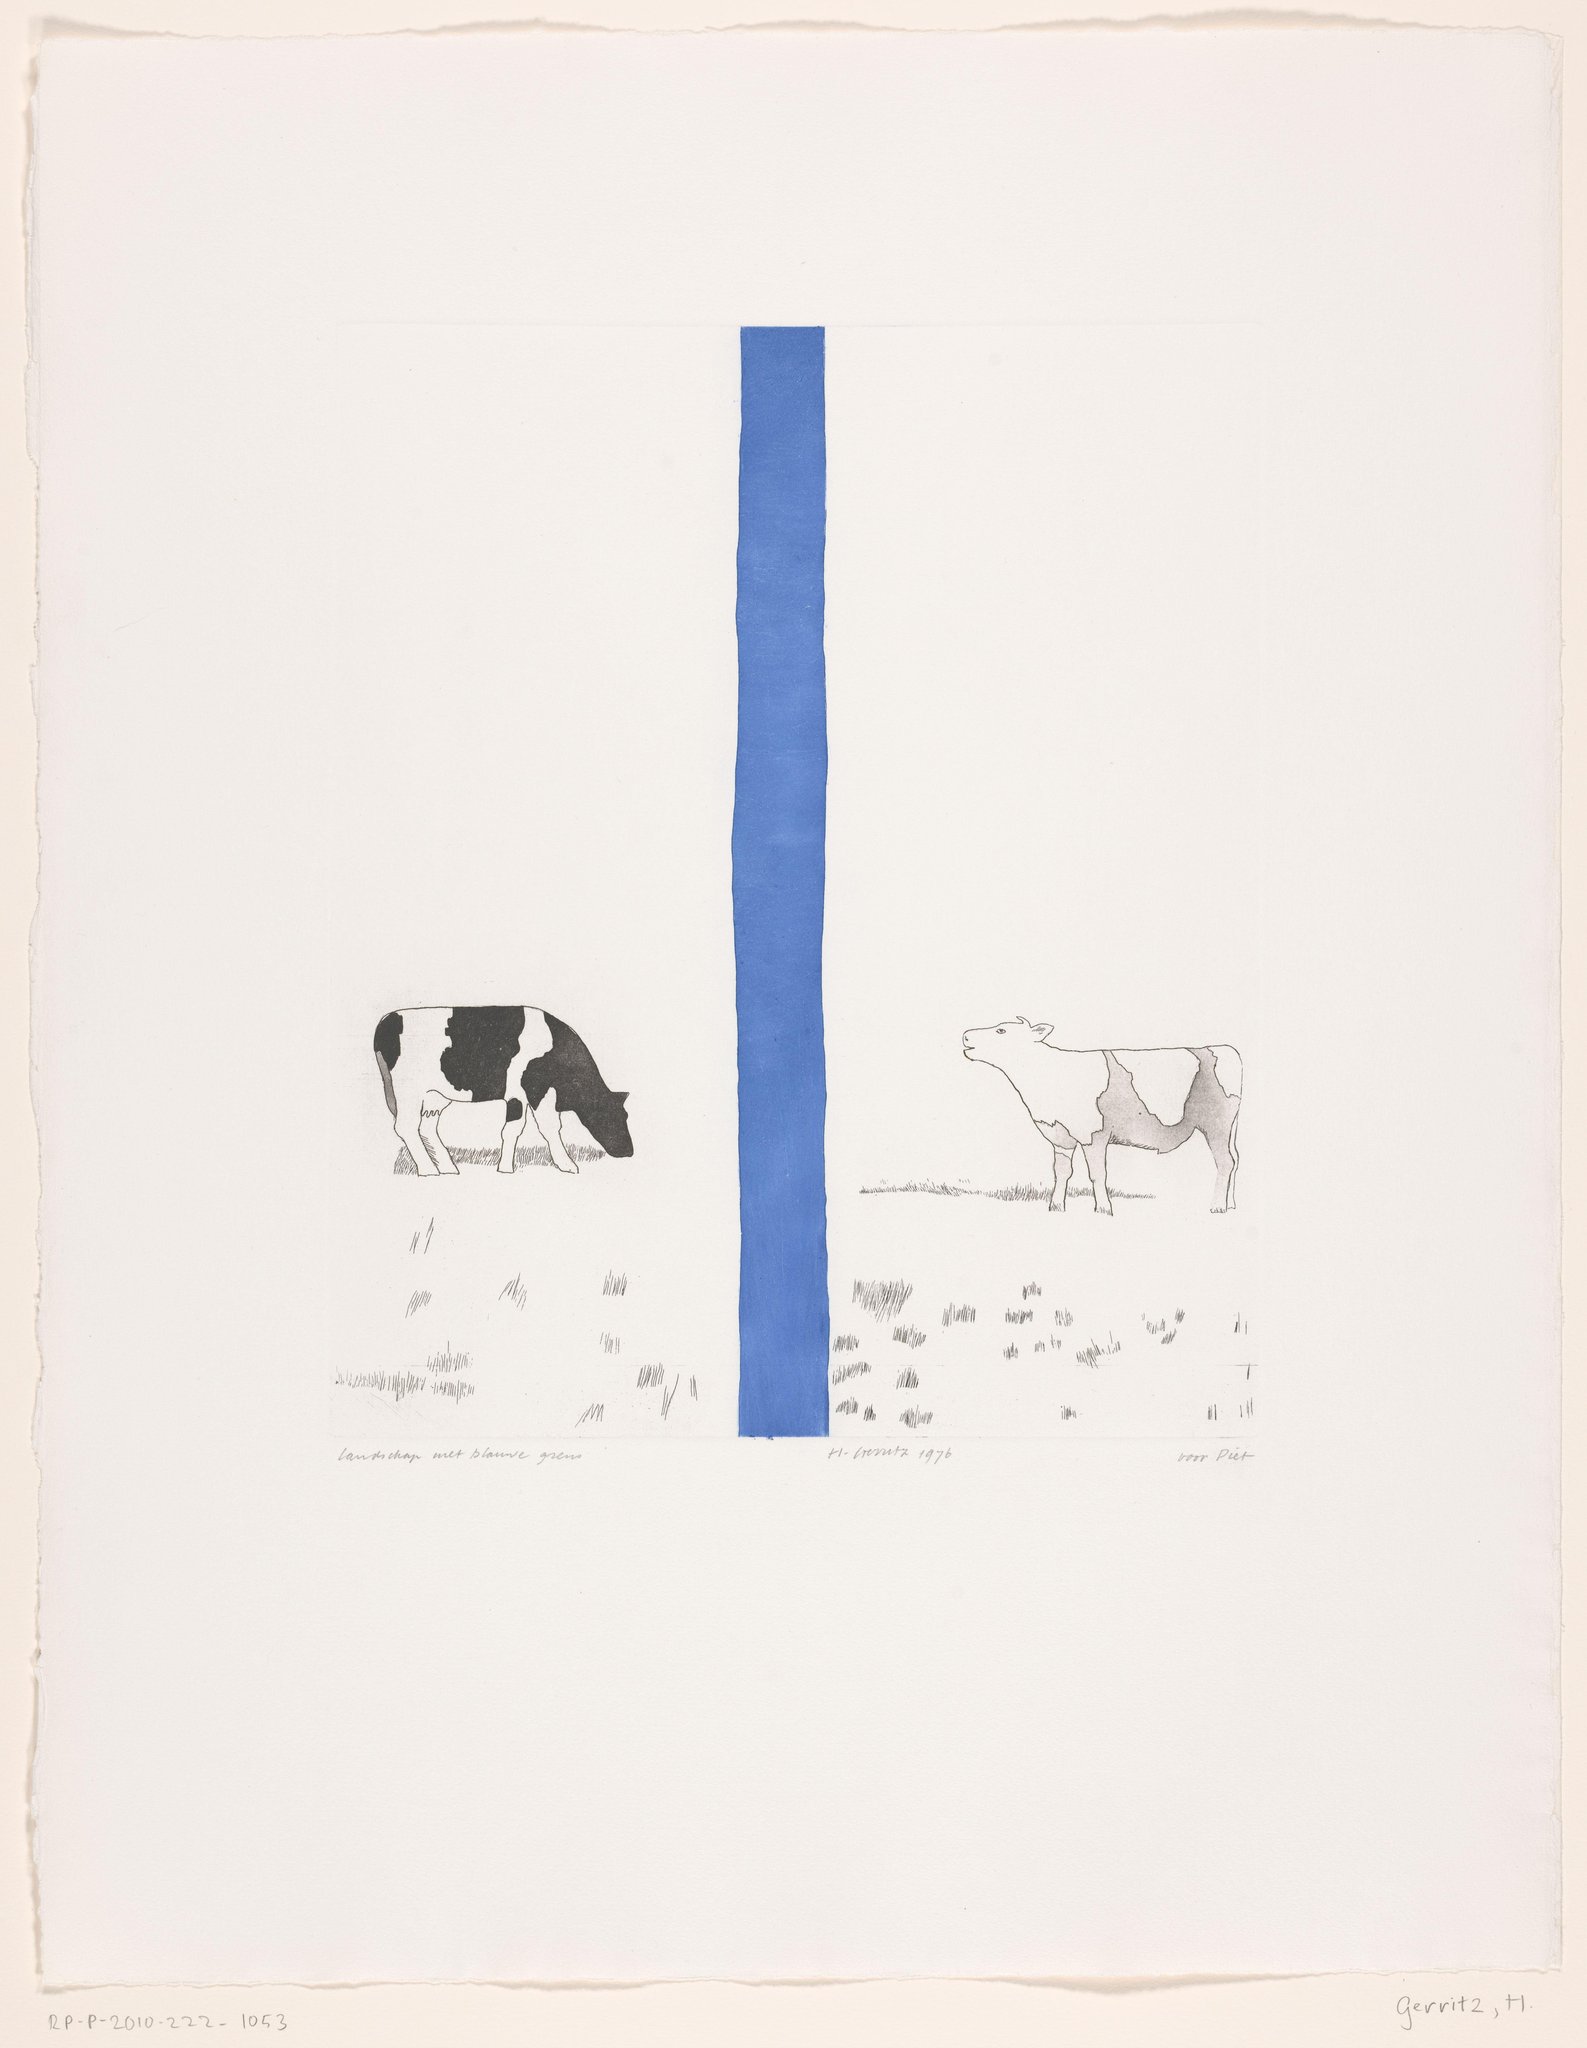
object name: print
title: Landschap met blauwe grens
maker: harrie a. gerritz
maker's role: draughtsman, painter, print maker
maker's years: 1940-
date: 1976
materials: paper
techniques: aquatint, etching, intaglio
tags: cow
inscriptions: inscription: ‘Shirley’, collector's mark: Lugt 2228, dedication: ‘voor Piet’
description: Twee koeien aan weerszijden van een blauwe balk.